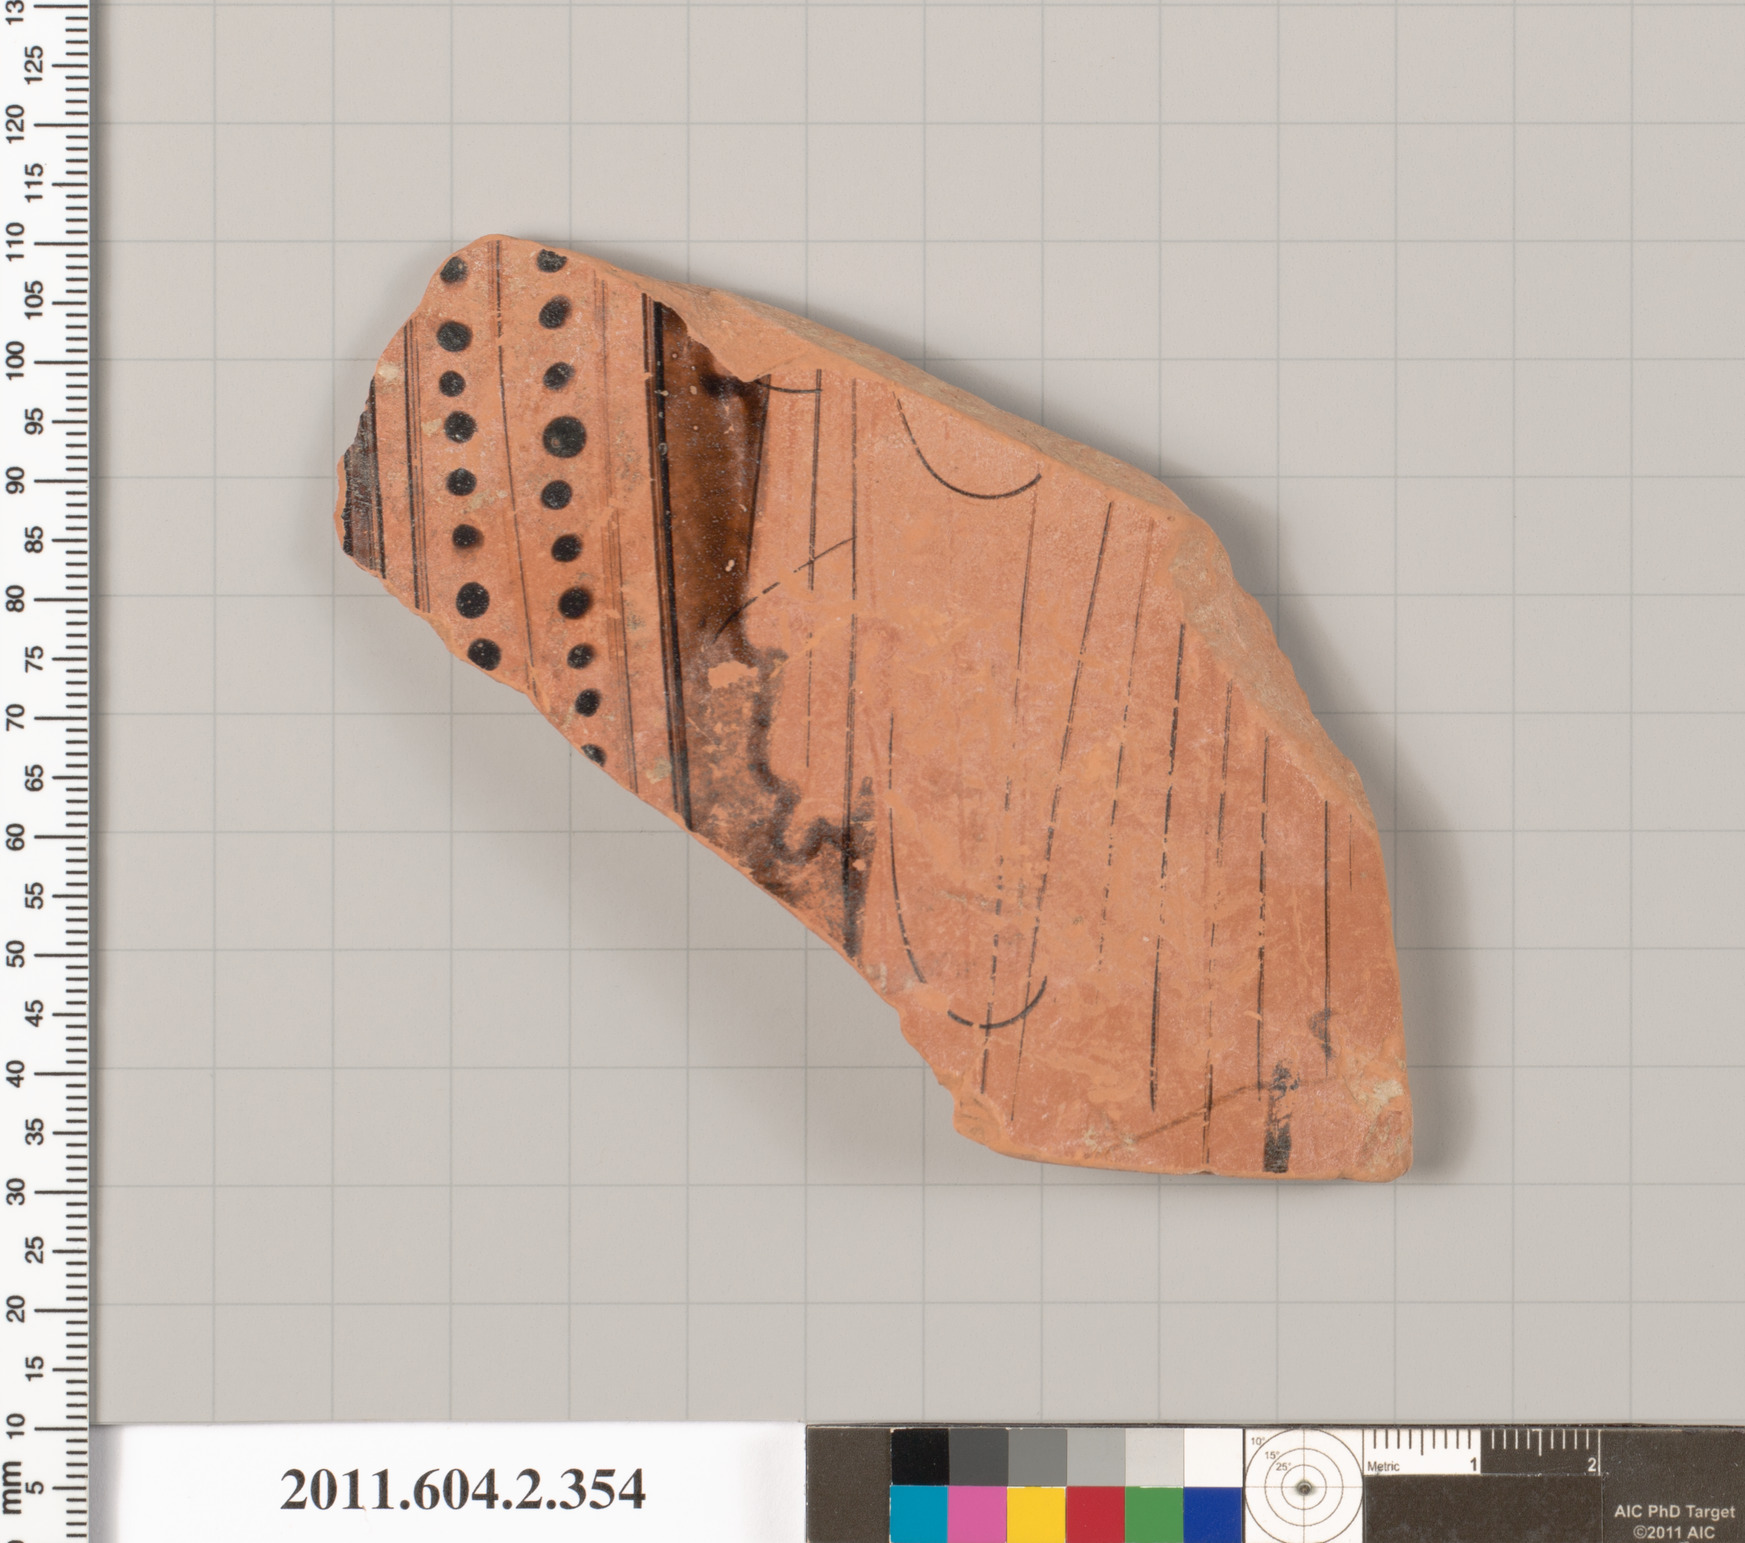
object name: column krater fragment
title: Terracotta fragment of a column-krater (bowl for mixing wine and water)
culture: greek, attic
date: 450-430 BCE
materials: terracotta